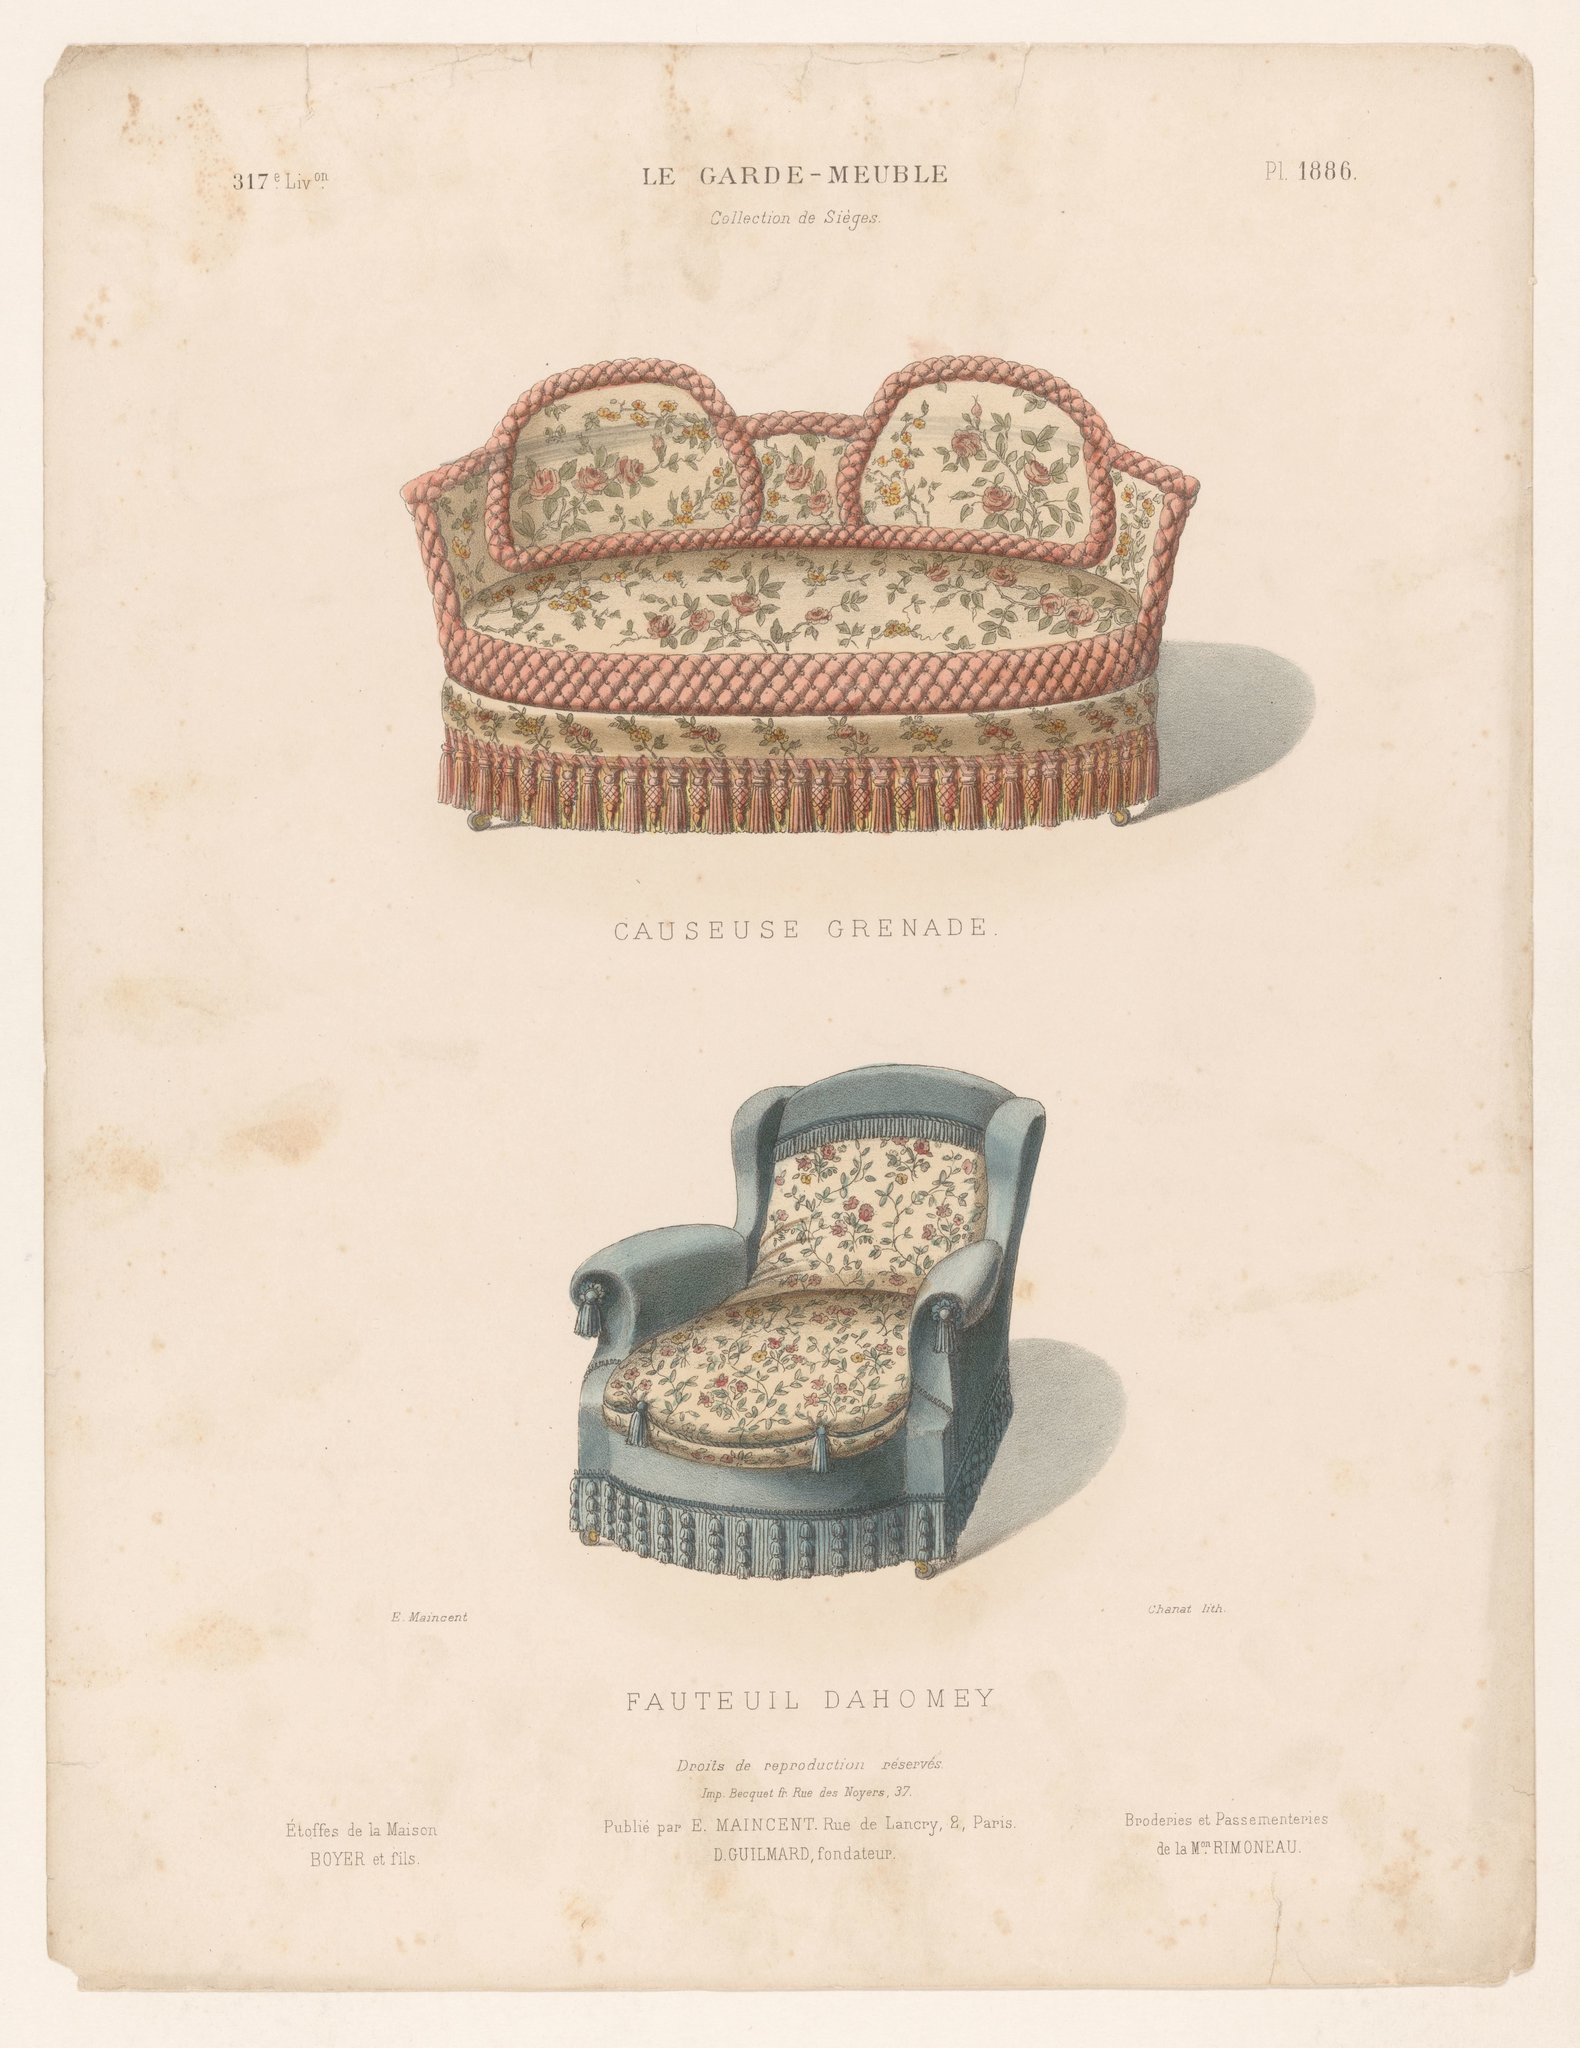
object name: print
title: Le garde-meuble / Collection de Sièges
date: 1885-1895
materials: paper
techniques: hand coloring, lithograph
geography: paris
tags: seating furniture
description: Ieder Livraison in de serie Le Garde-Meuble bevat negen platen: drie 'sièges' (zitmeubels), drie 'meubles' (diverse meubels zoals tafels en kasten) en drie 'tentures' (gordijnen en draperieën).